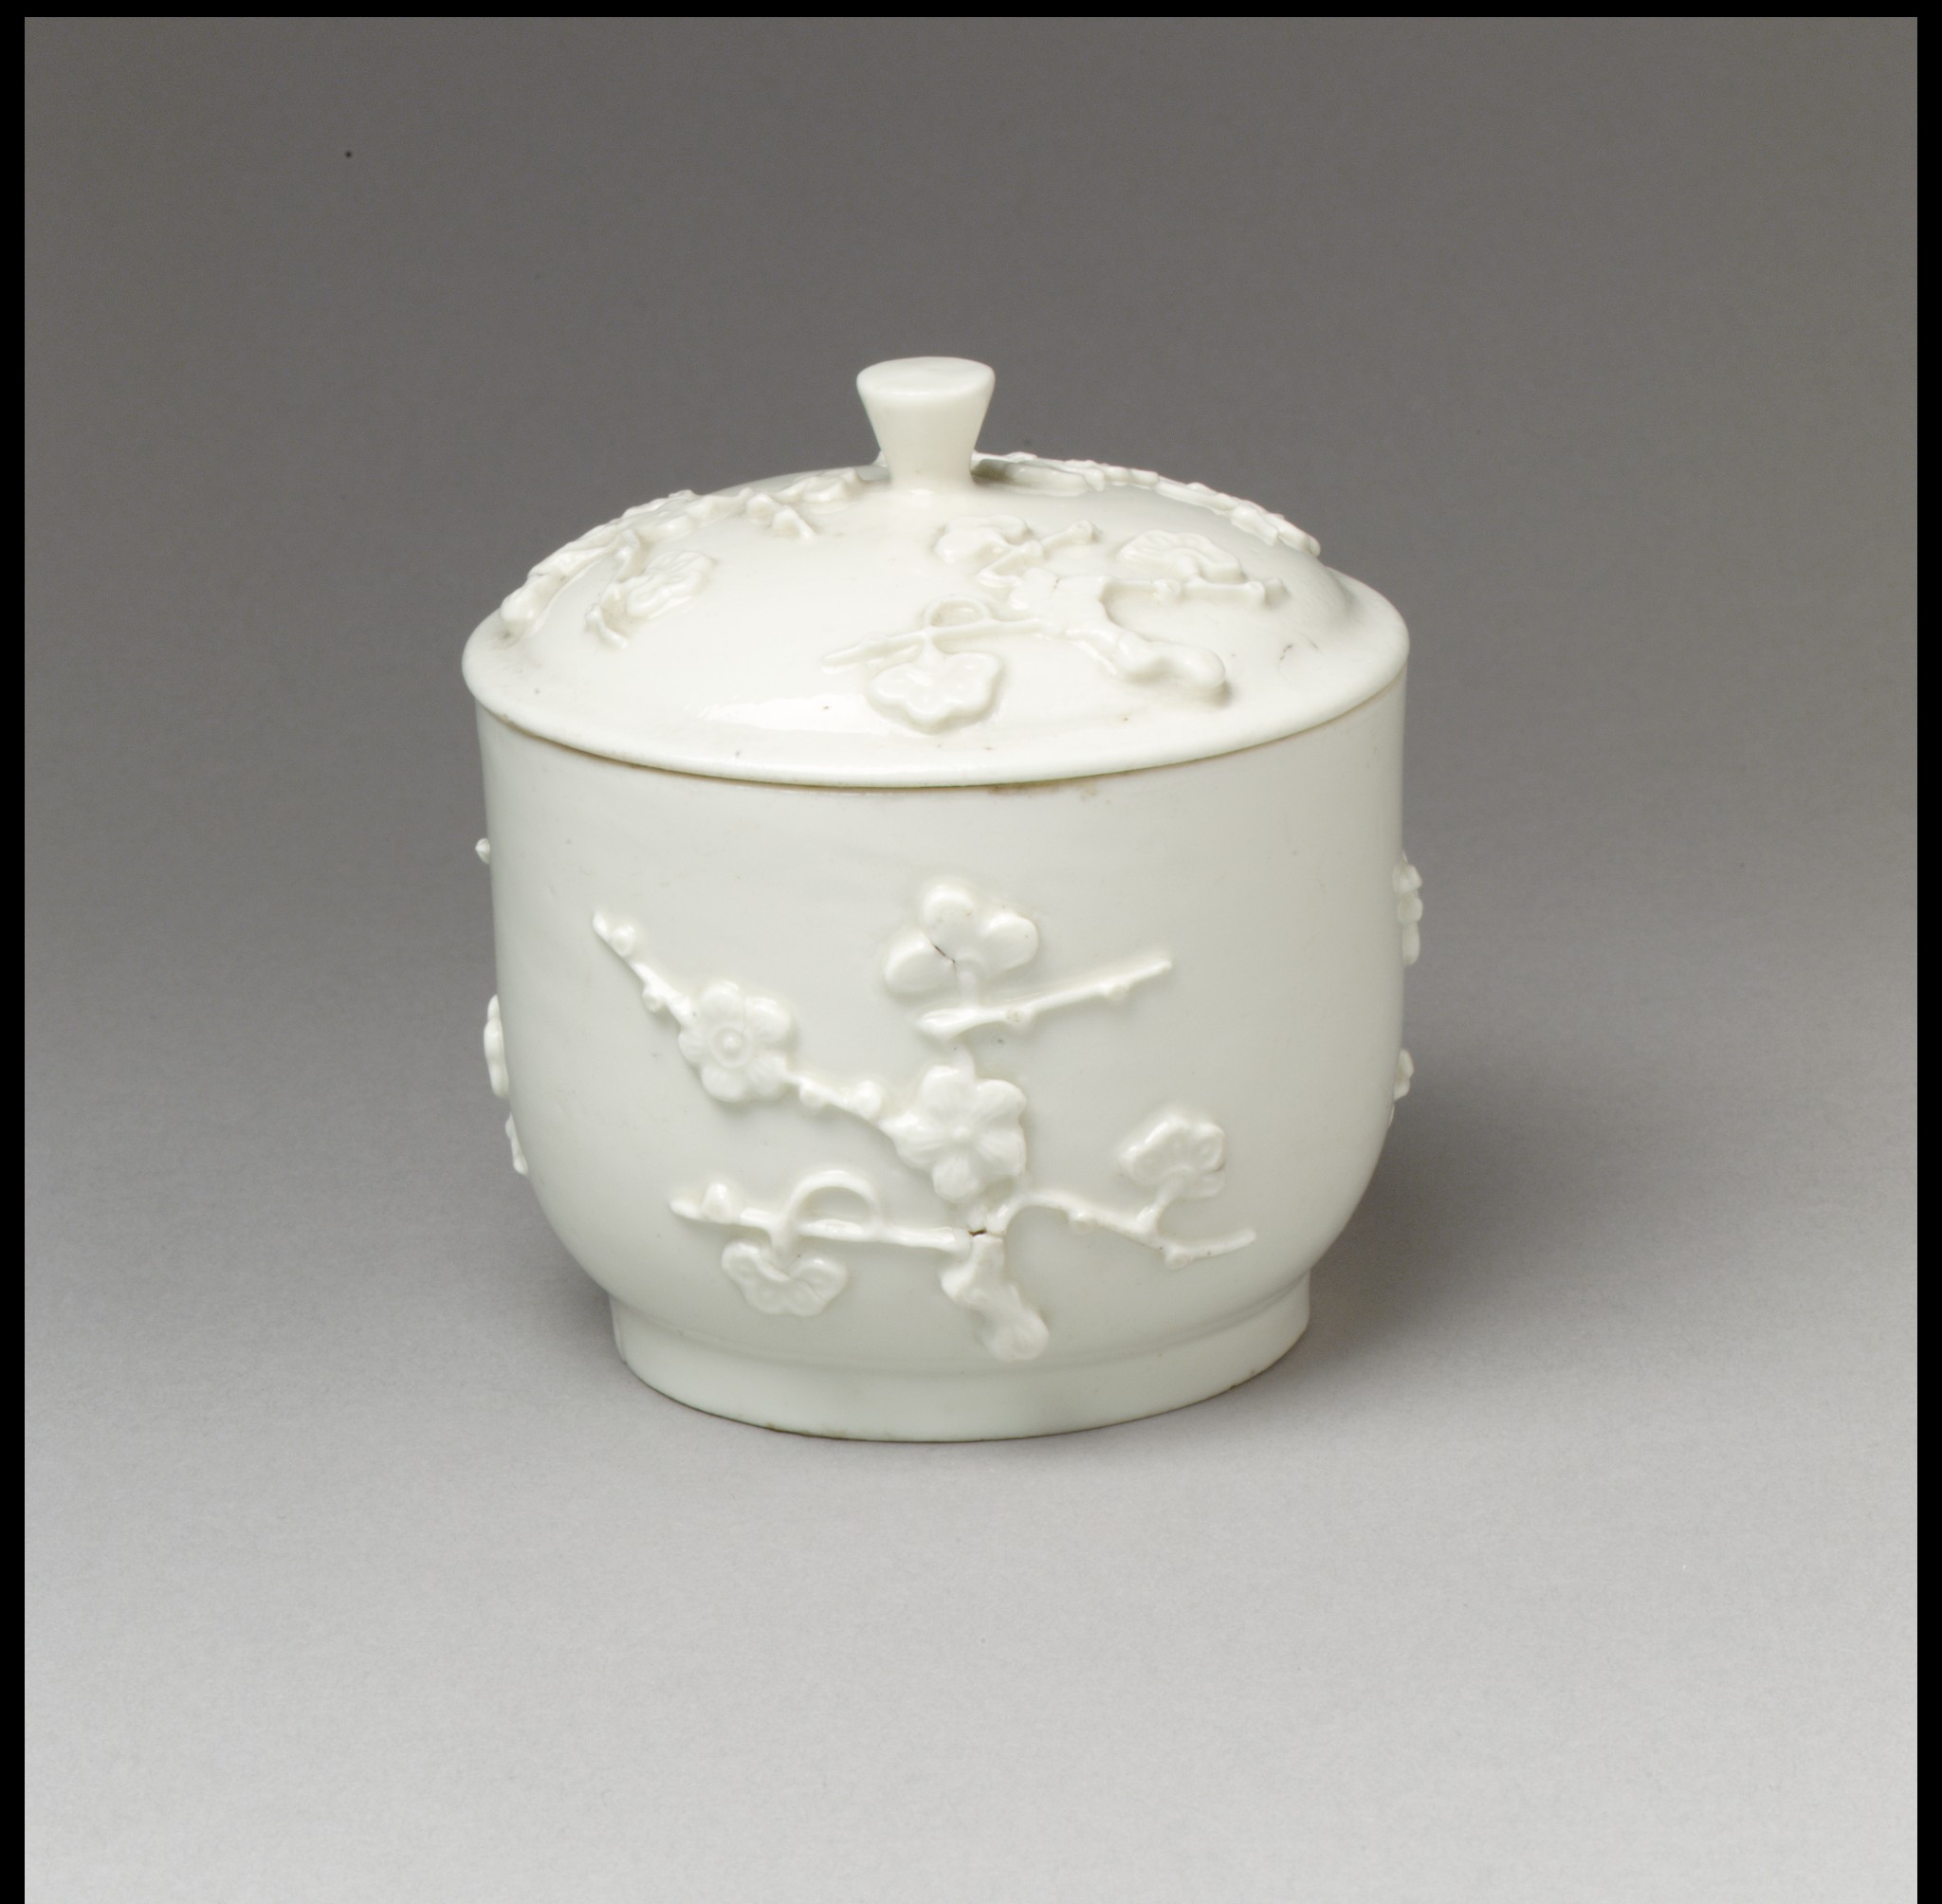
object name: jar with cover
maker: saint-cloud factory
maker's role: factory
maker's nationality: french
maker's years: 1693-1766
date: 1730-1750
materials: soft paste porcelain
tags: flowers